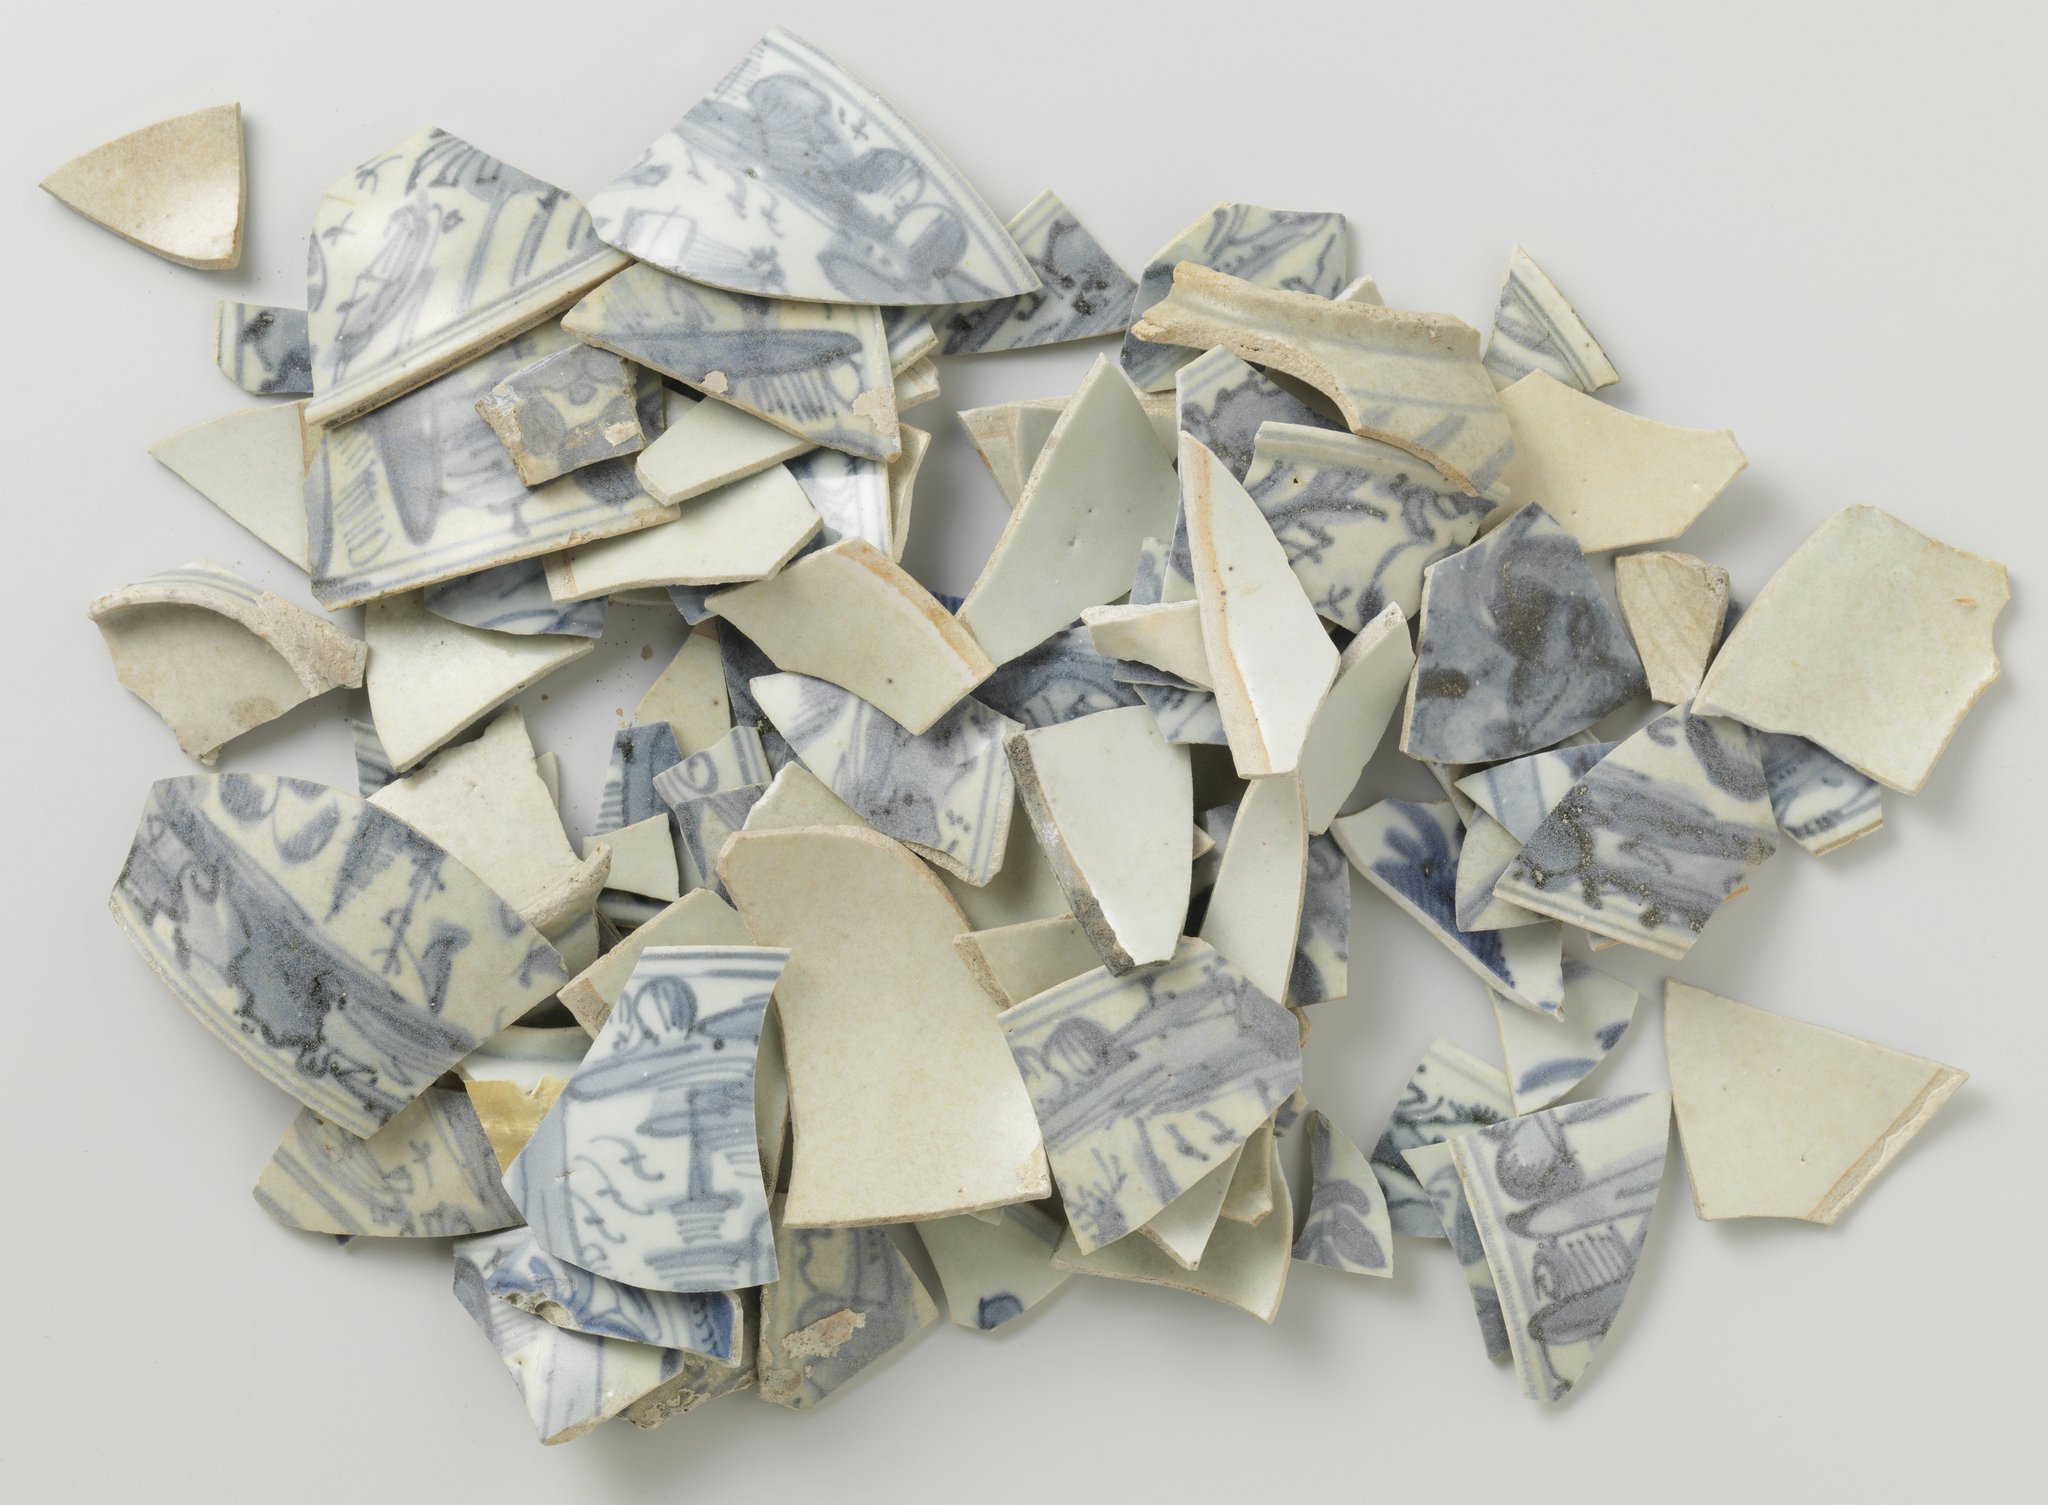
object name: lid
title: Scherven van kommen en deksels van porselein uit V.O.C.-schip de 'Witte Leeuw'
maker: Anonymous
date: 1613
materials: porcelain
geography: jingdezhen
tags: verenigde oostindische compagnie, sint-helena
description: Scherven van kommen en deksels van porselein uit V.O.C.-schip de 'Witte Leeuw'.